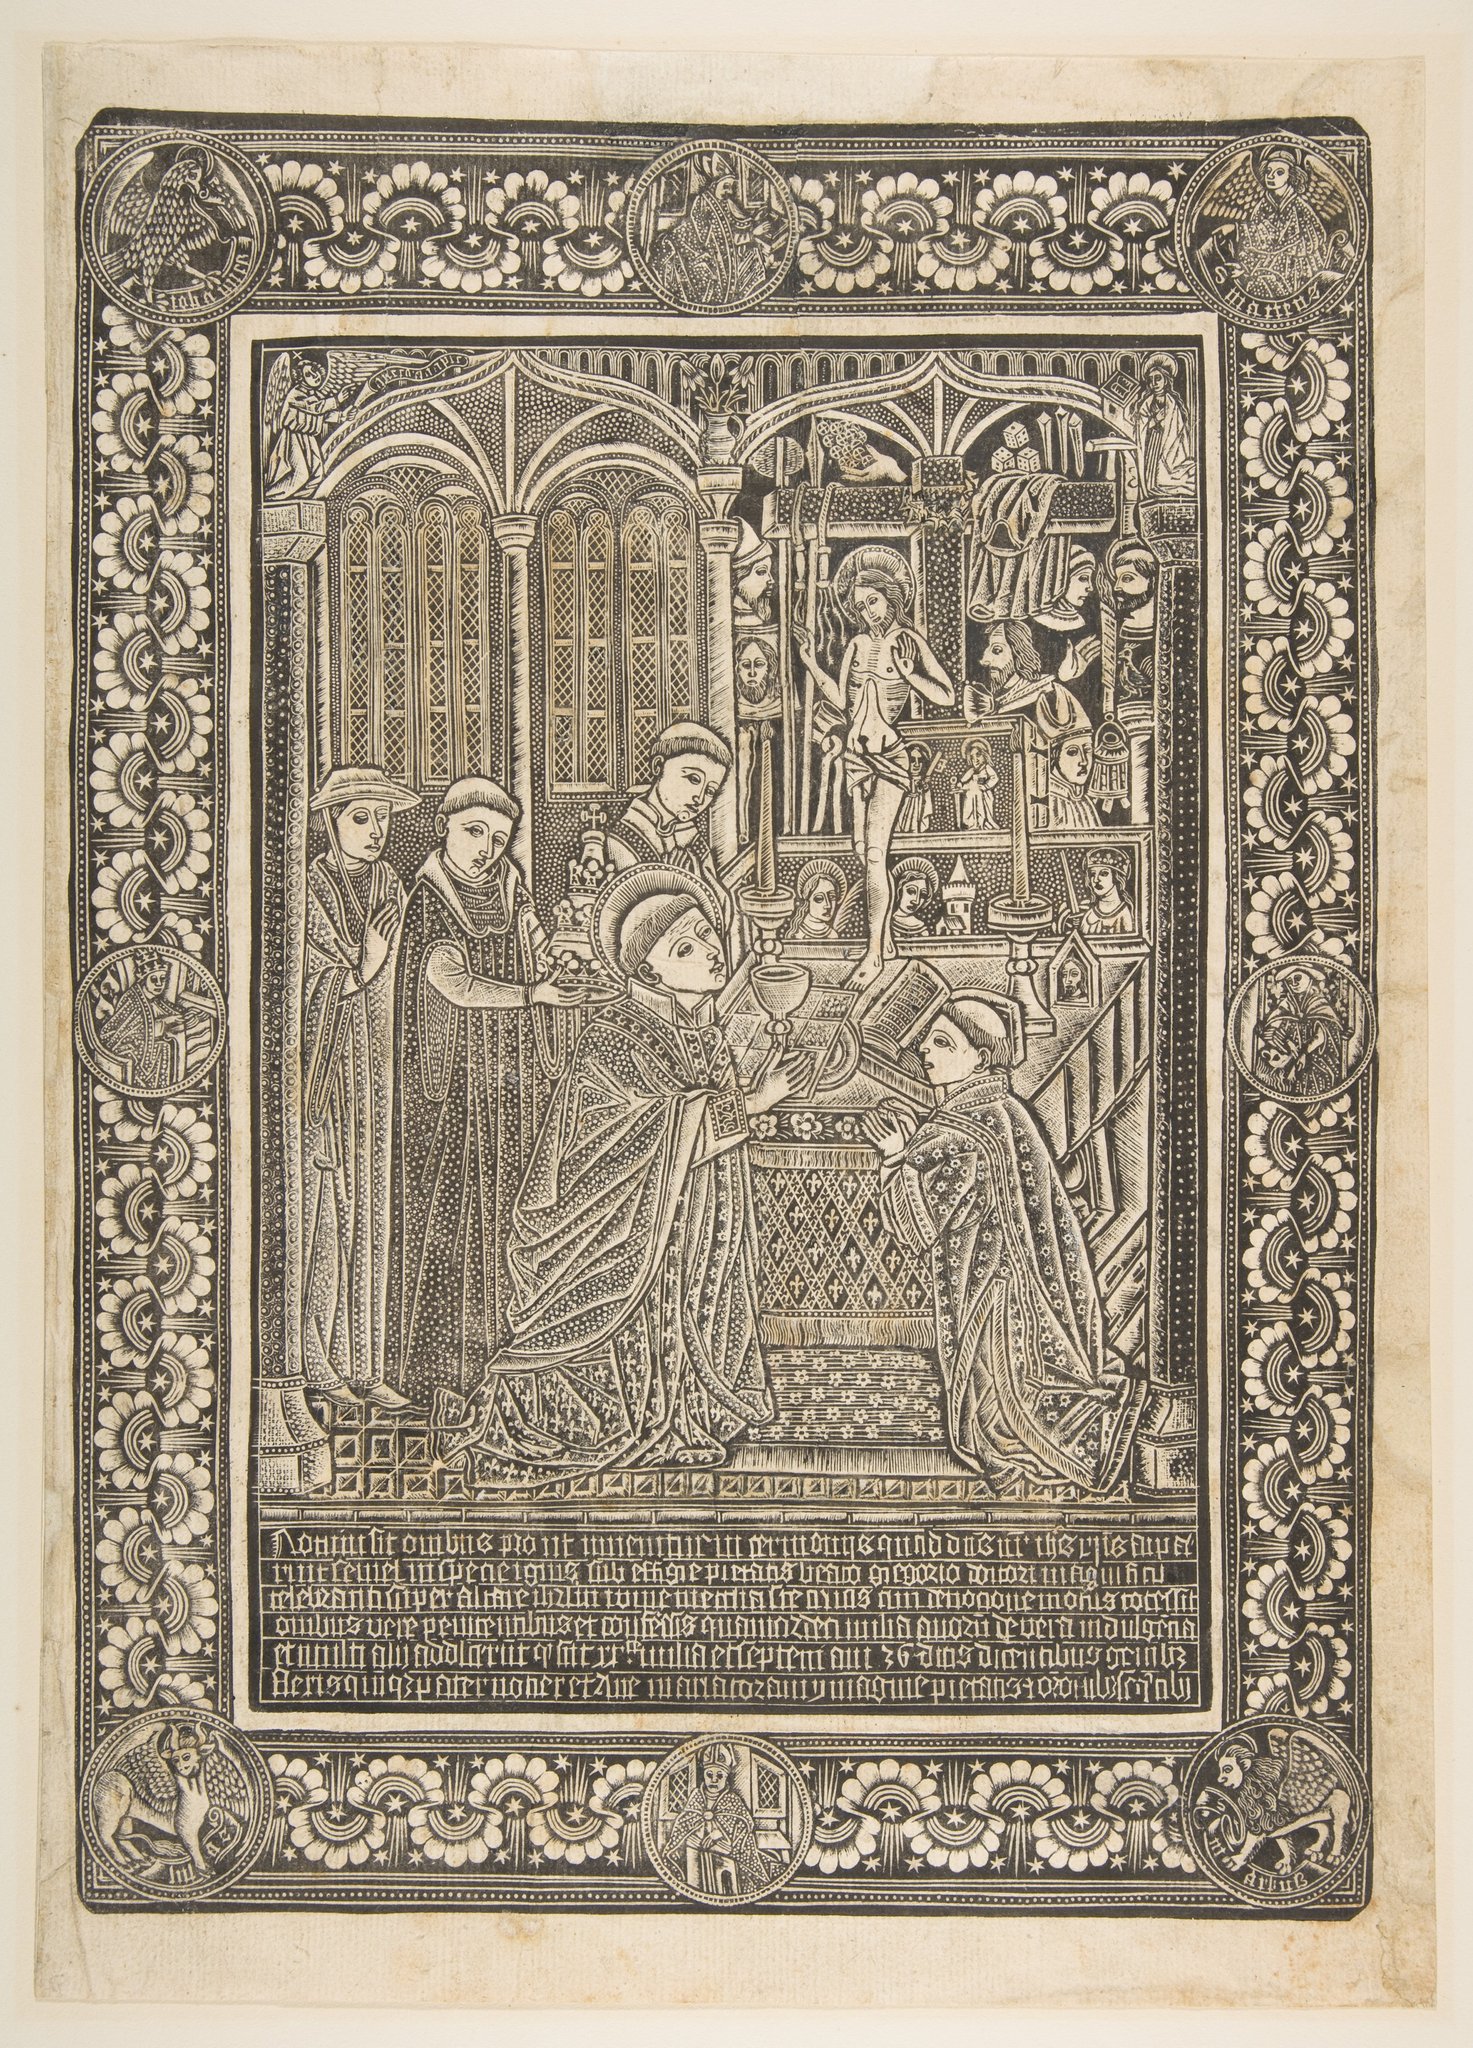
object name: print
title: The Mass of Saint Gregory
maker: master of the church fathers' border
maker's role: artist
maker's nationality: german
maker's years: 1450-1500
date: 1467-1500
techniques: hand coloring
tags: stars,angels,saints